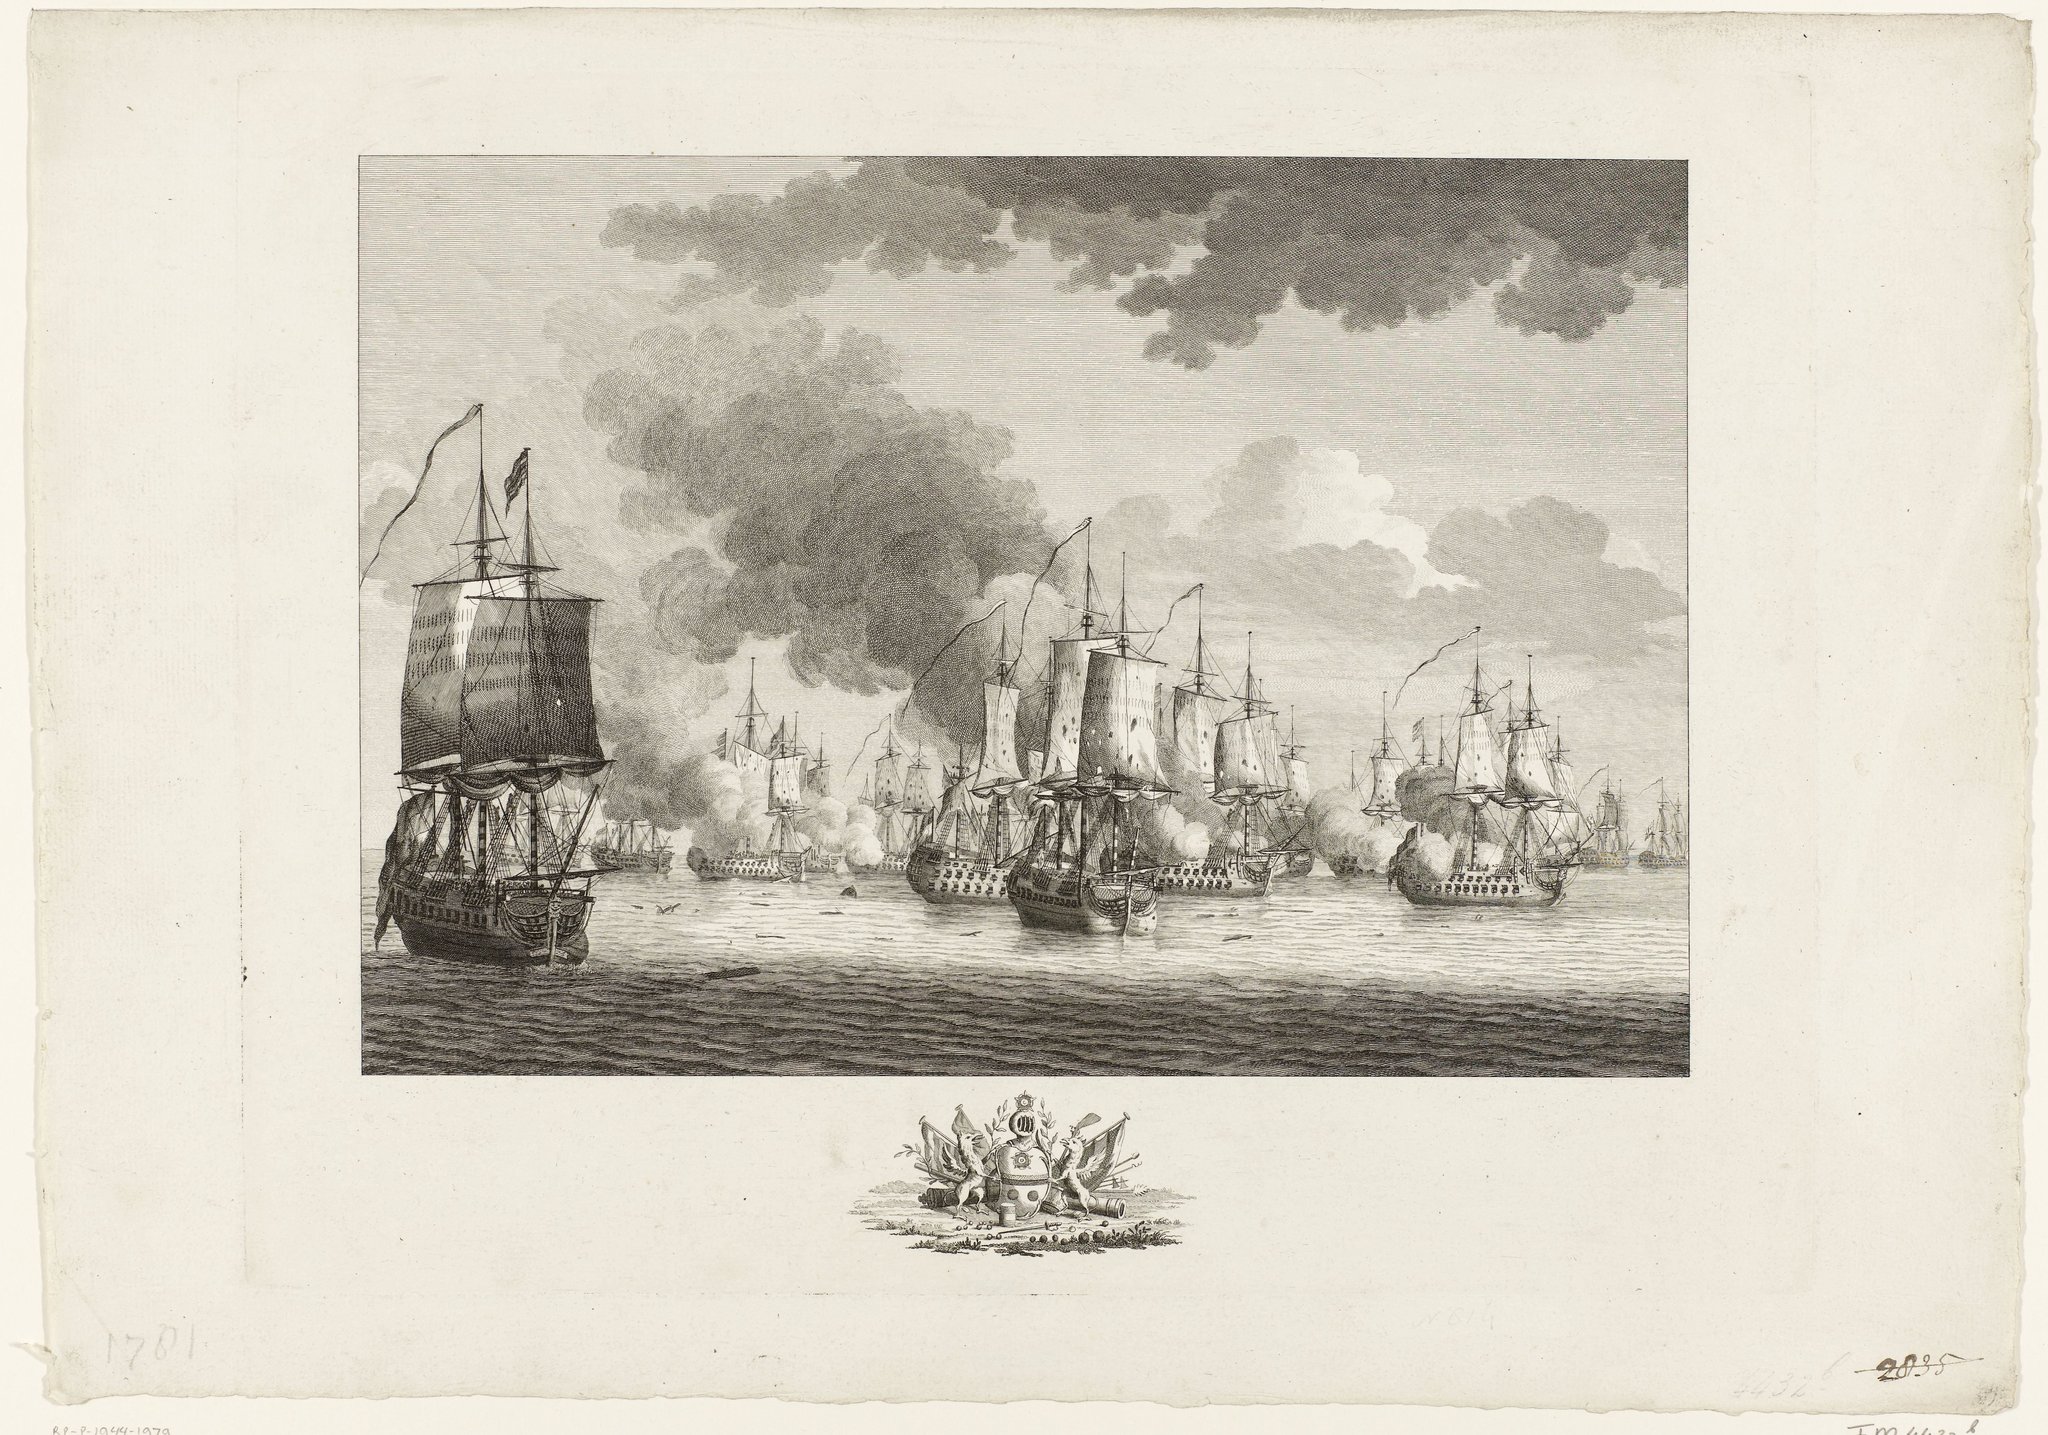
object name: print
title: Zeeslag bij Doggersbank, 1781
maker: cornelis bogerts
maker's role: print maker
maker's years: 1745-1817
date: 1781-1784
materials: paper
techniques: engraving, etching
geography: northern netherlands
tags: the hague, johan arnold zoutman, hyde parker, battle (+ naval force)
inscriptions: collector's mark: Lugt 2228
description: De Nederlandse en Engelse schepen tijdens de zeeslag bij Doggersbank op 5 augustus 1781 tussen de Nederlandse vloot onder schout-bij-nacht Johan Zoutman en de Engelse vloot onder vice-admiraal Hyde Parker. In de marge alleen in het midden het wapen van Zoutman.